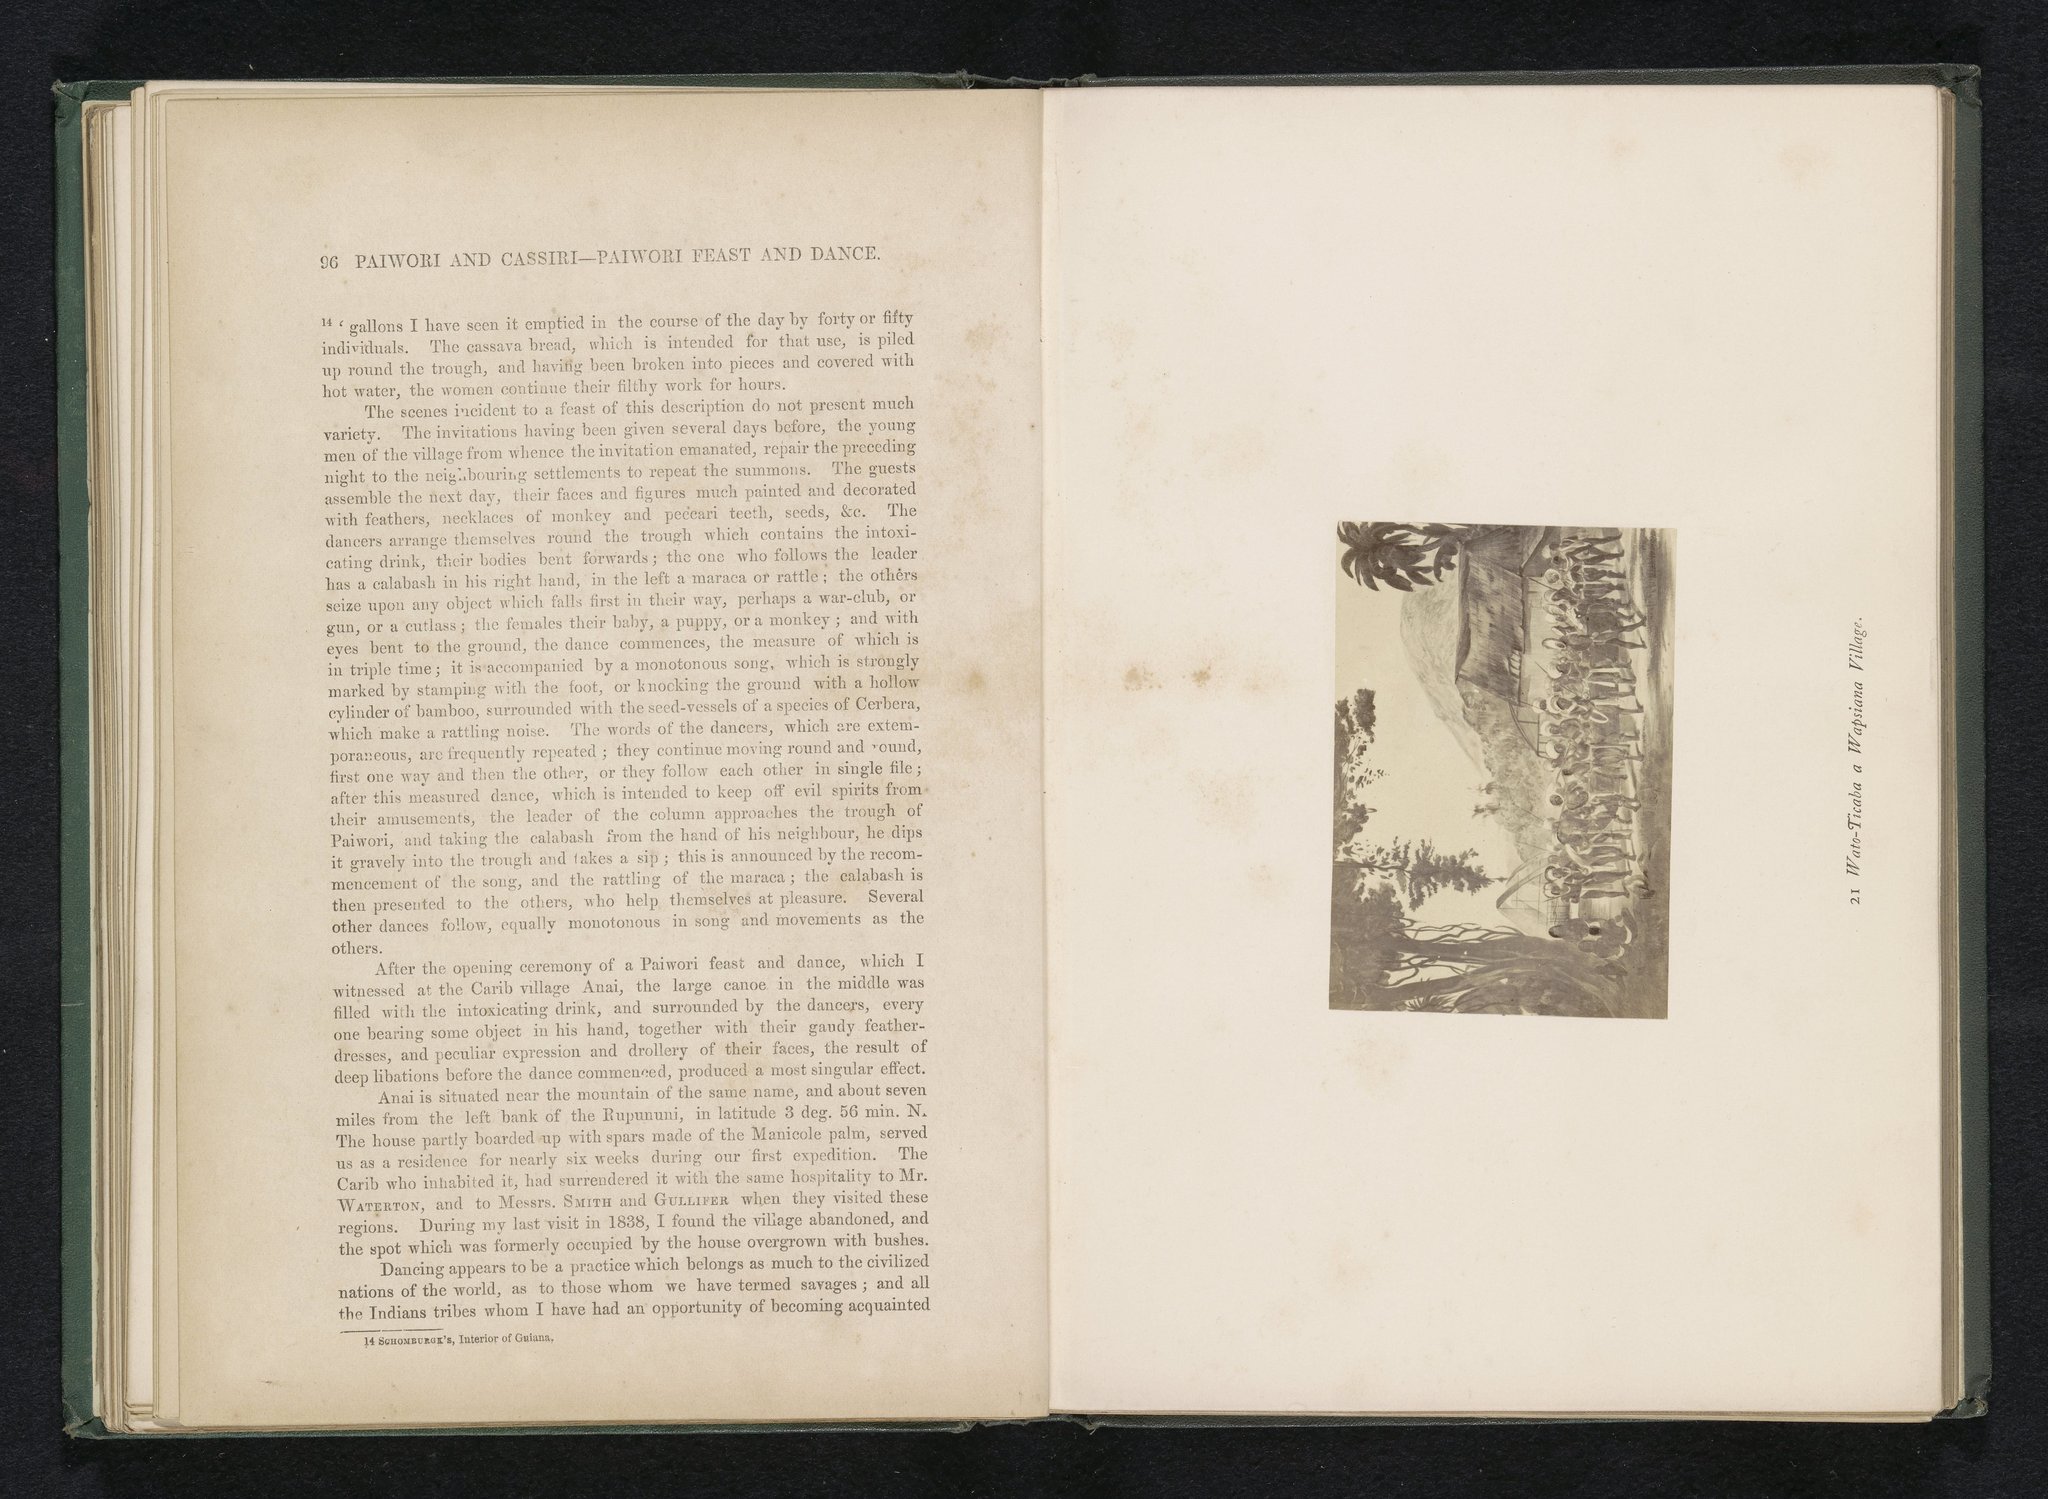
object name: page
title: Wato-Ticaba a Wapsiana Village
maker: Anonymous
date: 1856-1866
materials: photographic support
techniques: albumen print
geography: guyana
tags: village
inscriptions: number: ‘21’